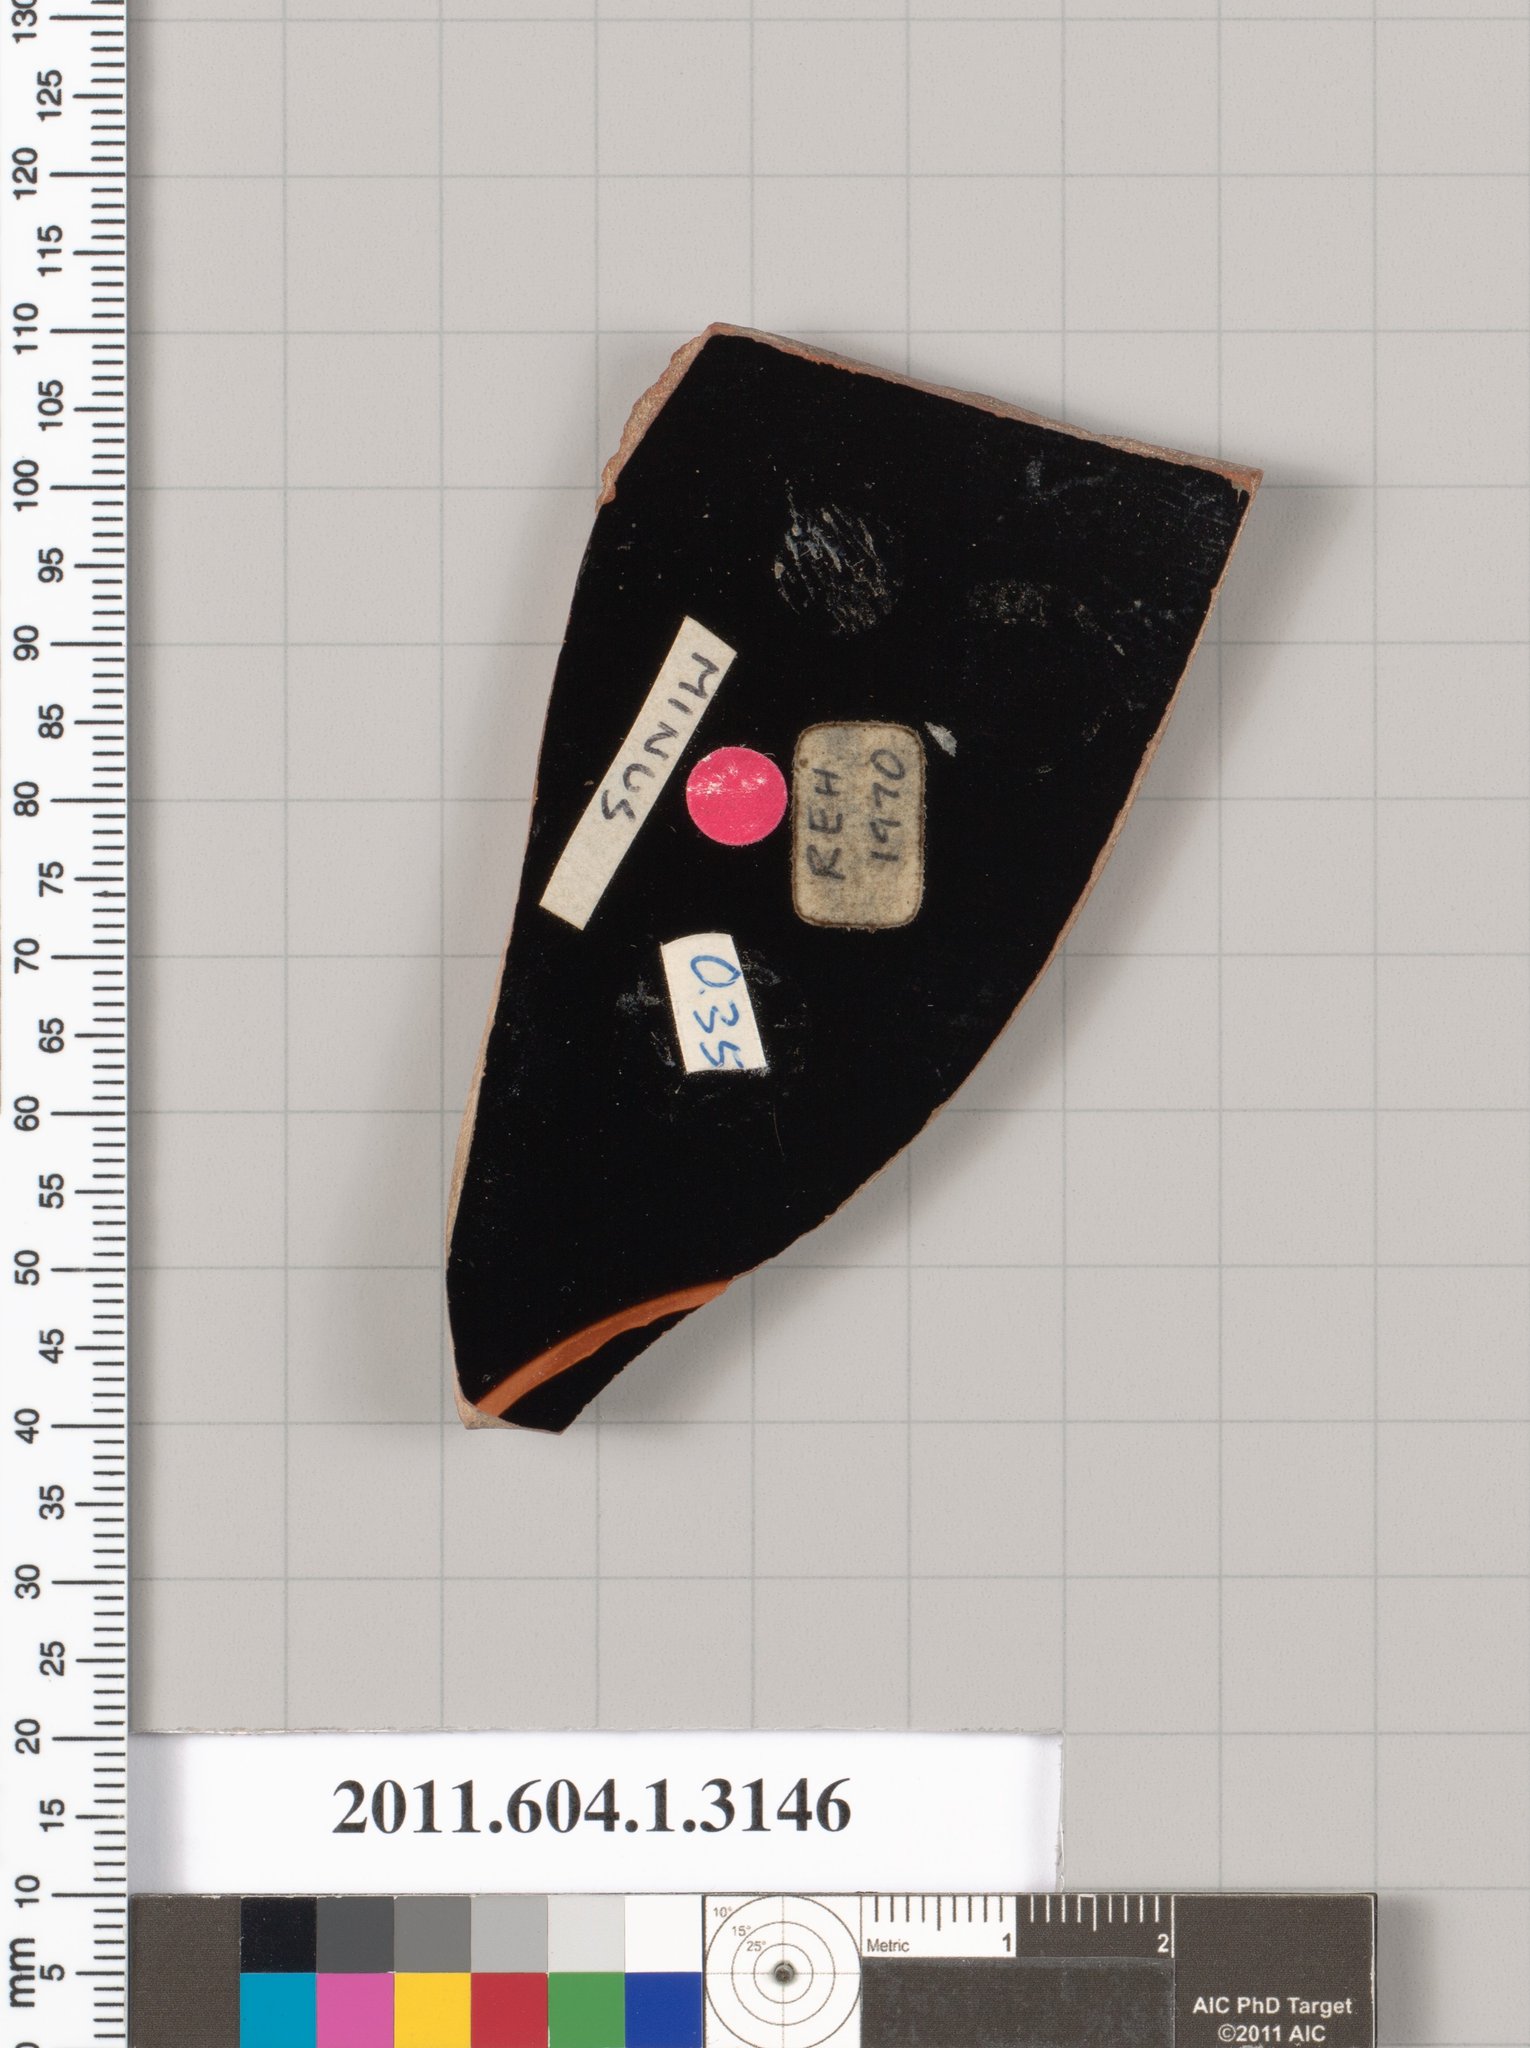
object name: kylix fragment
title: Terracotta fragment of a kylix (drinking cup)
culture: greek, attic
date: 534-501 BCE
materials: terracotta